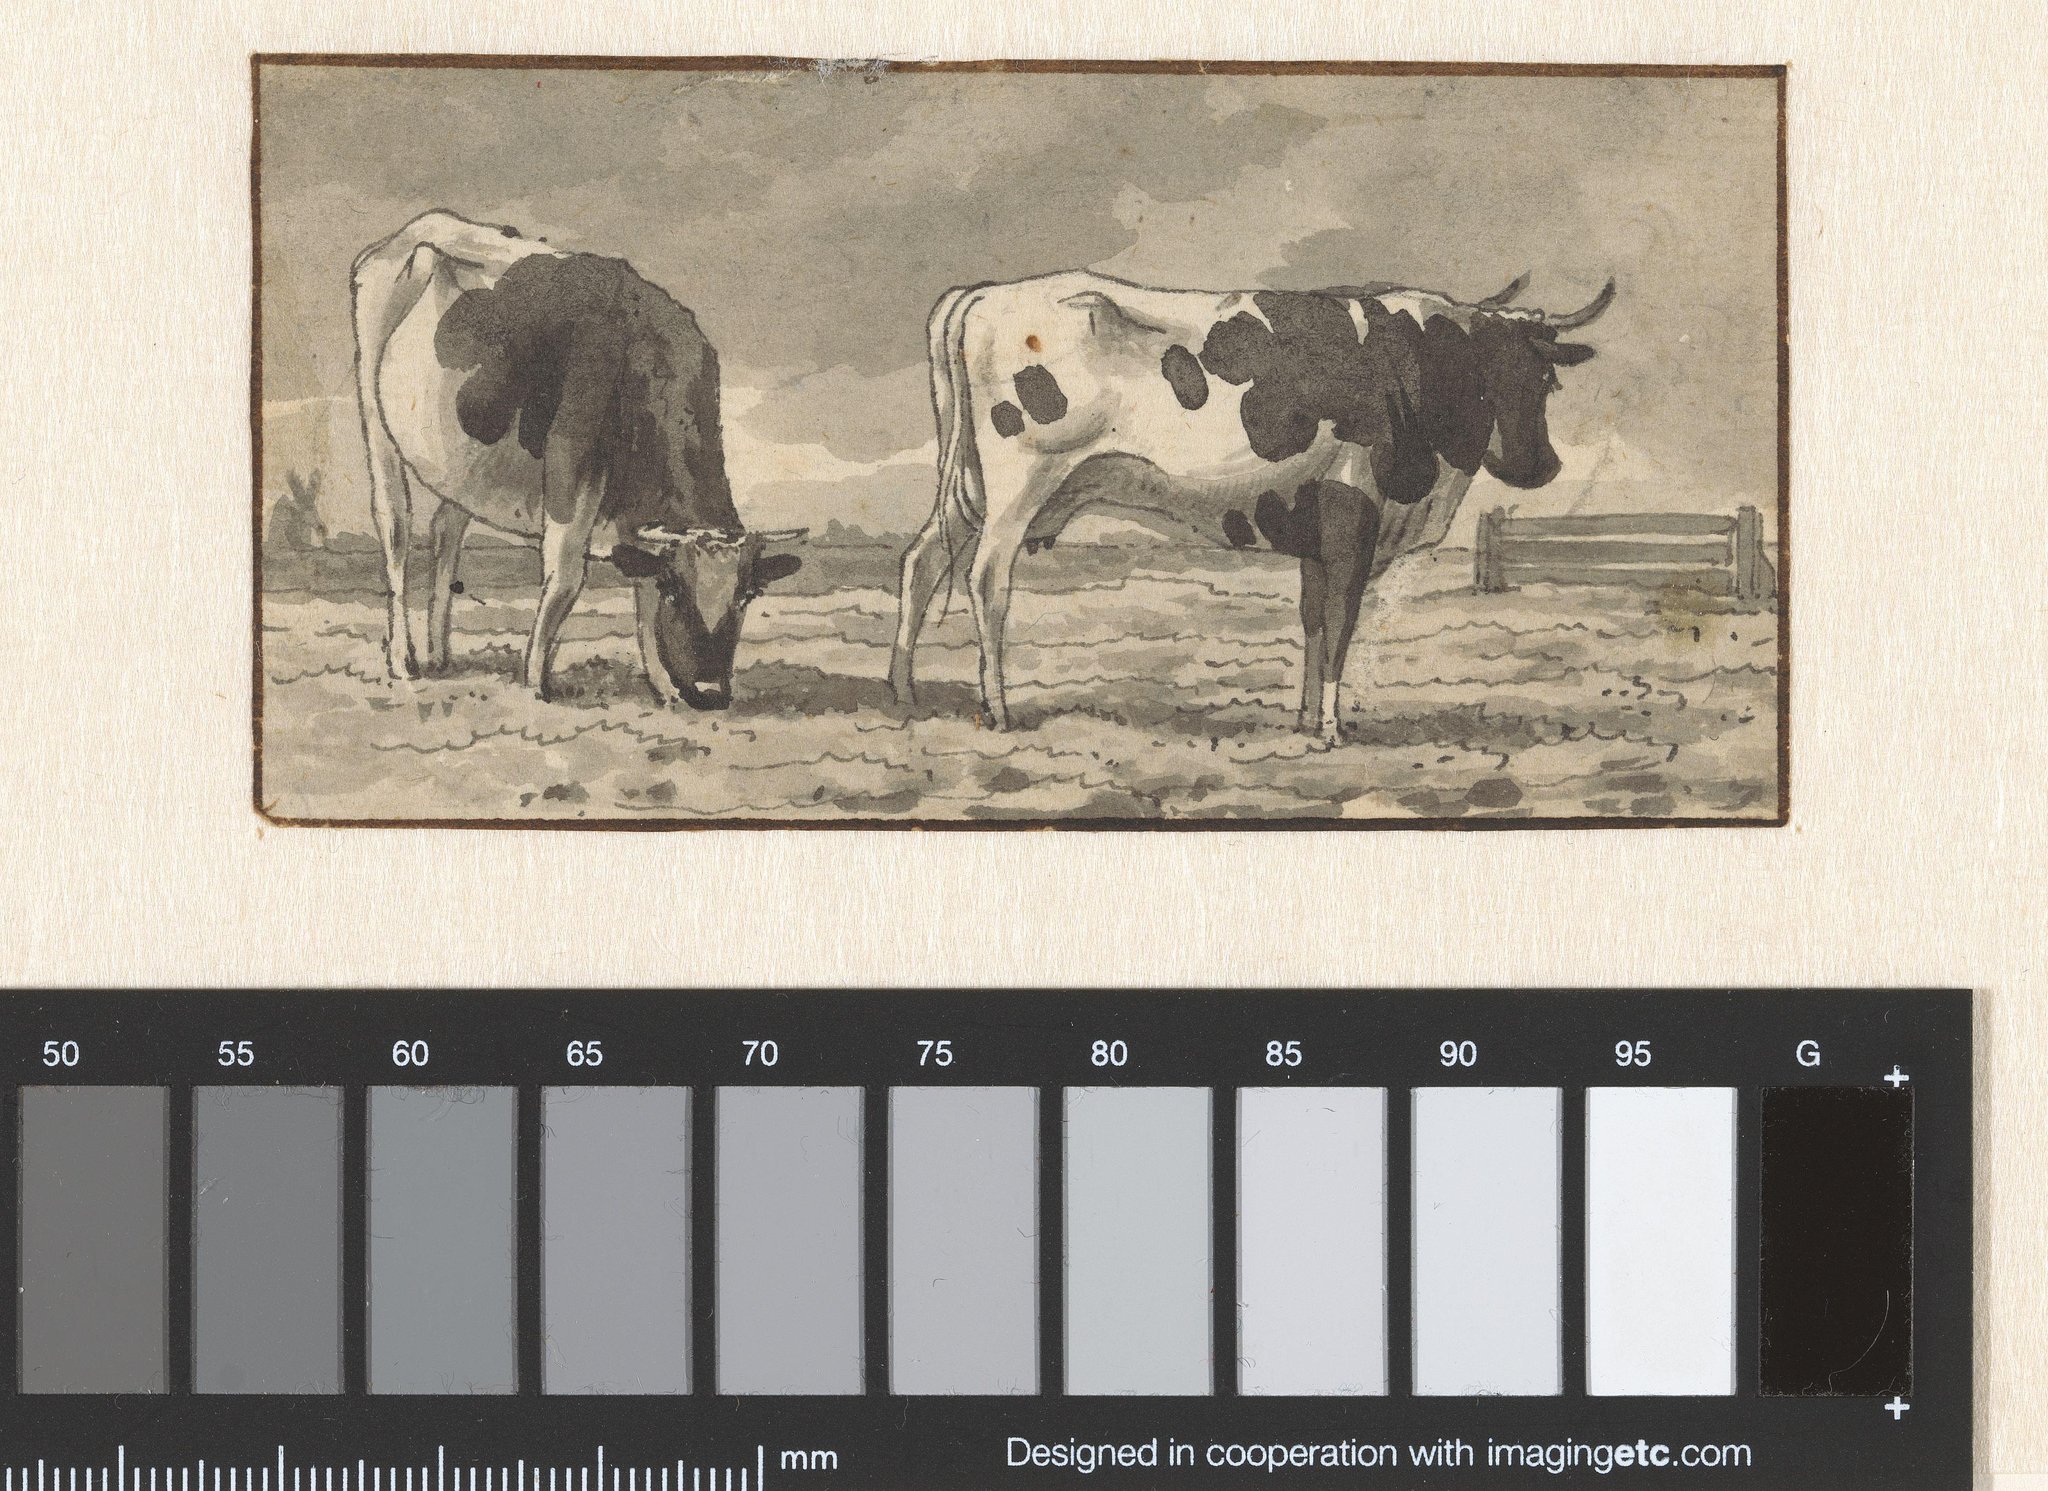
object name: drawing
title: Studie van twee koeien in een wei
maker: wouter johannes van troostwijk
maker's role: draughtsman, painter, print maker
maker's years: 1782-1810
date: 1802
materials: ink, paper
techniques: brush, pen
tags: cow, meadow, pasture